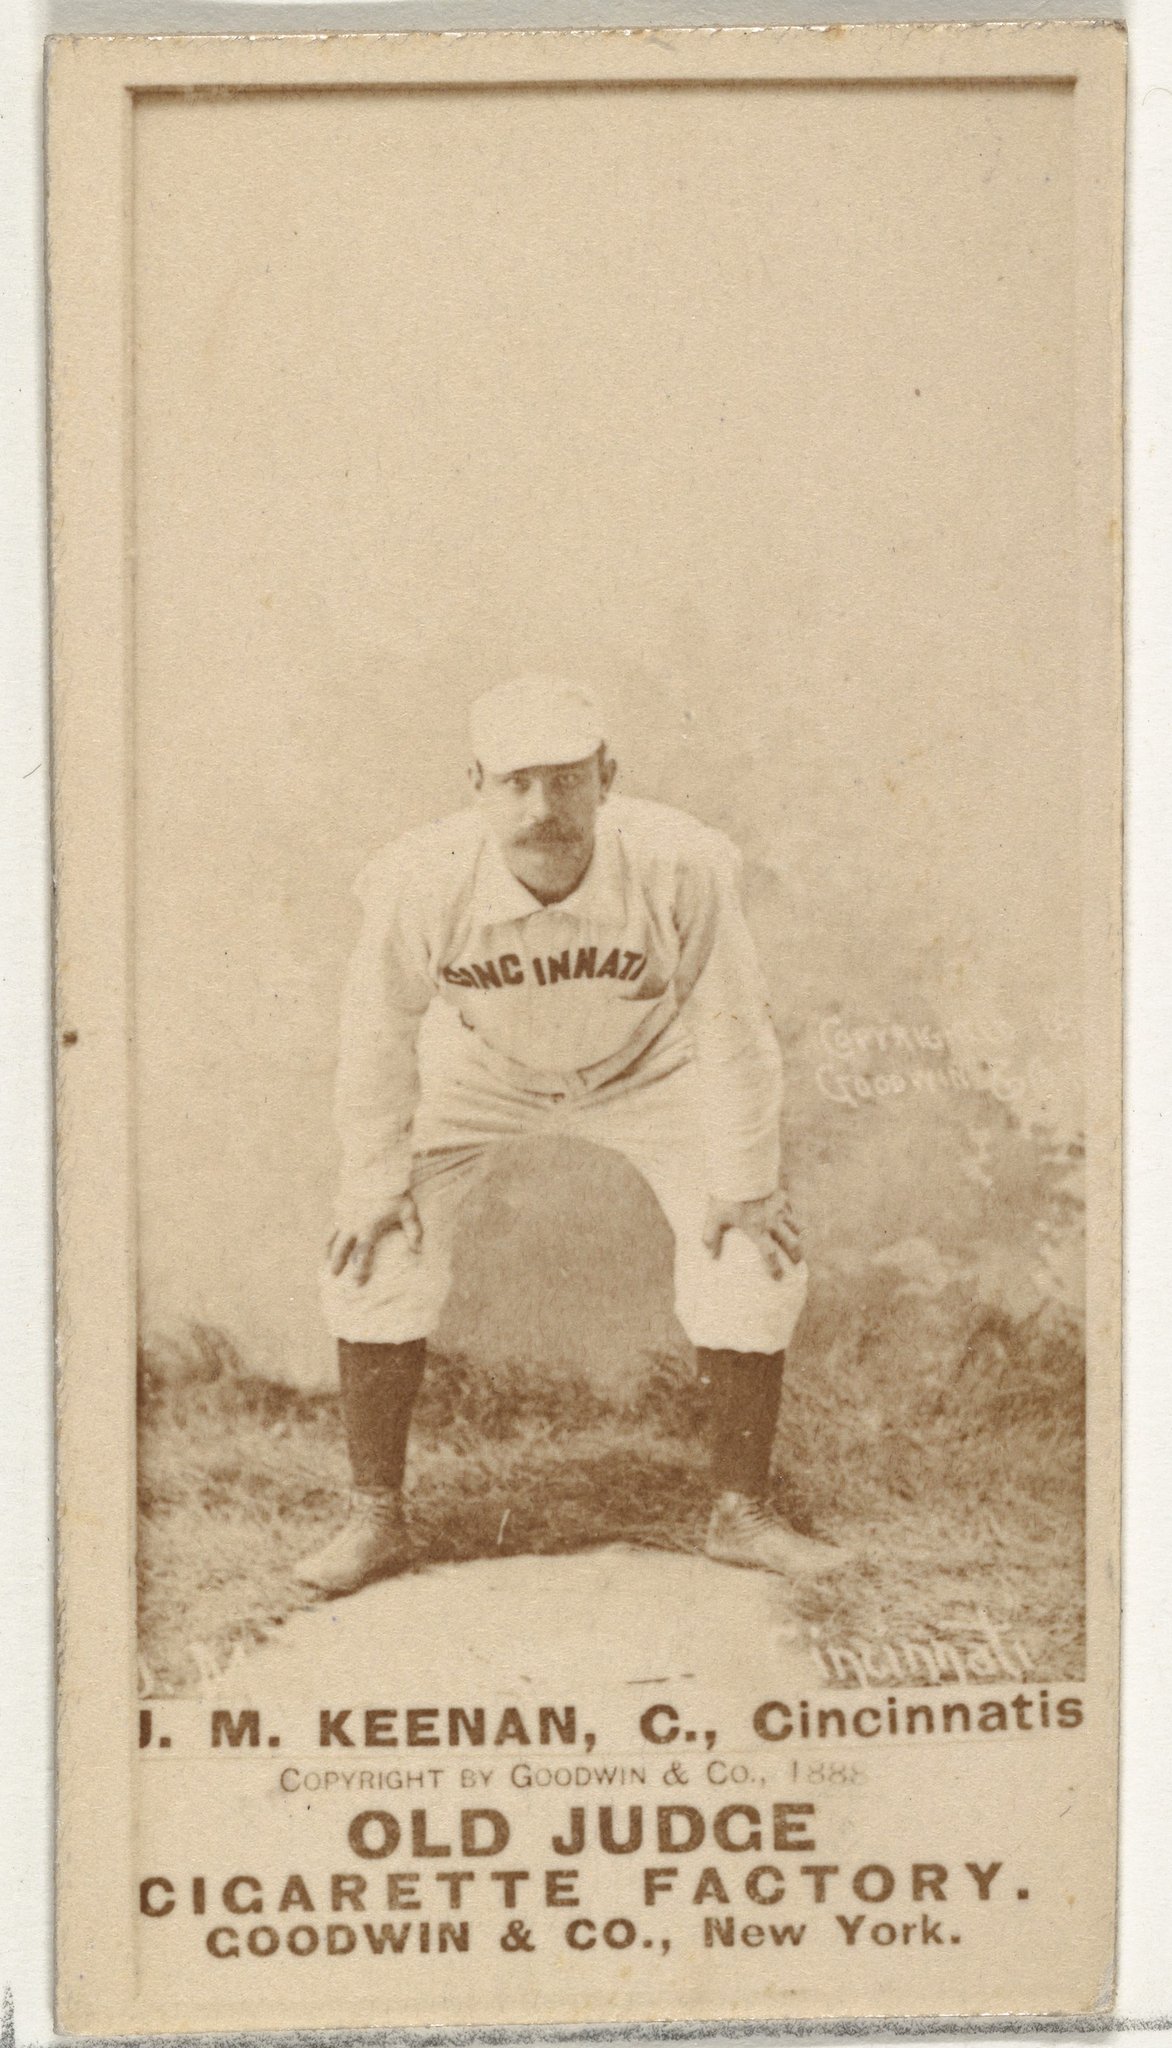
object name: baseball card, photograph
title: James William "Jim" Keenan, Catcher, Cincinnati, from the Old Judge series (N172) for Old Judge Cigarettes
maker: goodwin & company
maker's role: publisher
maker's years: 1850-1950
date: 1888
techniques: albumen silver print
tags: men,portraits,baseball,athletes